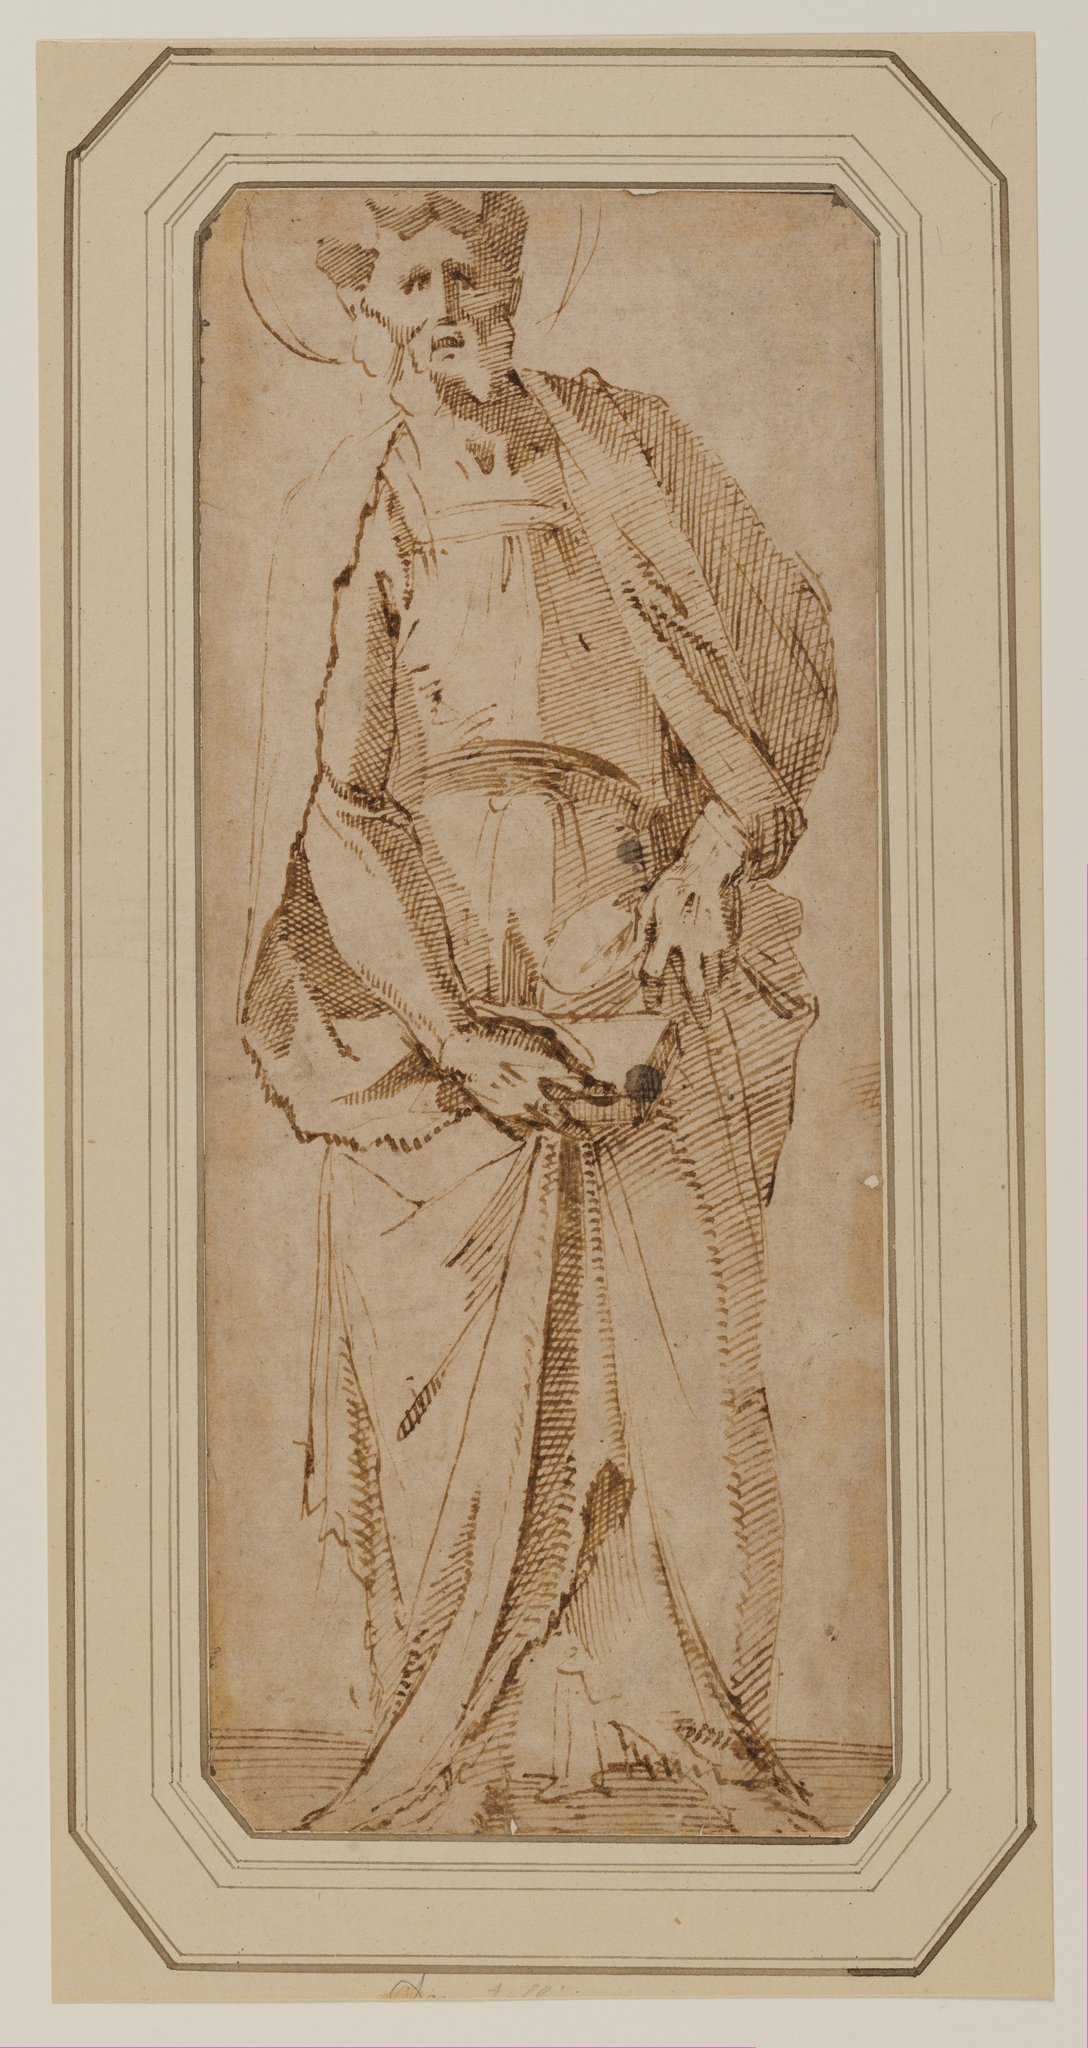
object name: drawing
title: Standing Apostle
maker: giovanni bandini (called giovanni dell'opera)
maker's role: artist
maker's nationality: italian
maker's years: 1540-1599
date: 1534-1566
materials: ink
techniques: pen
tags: men,apostles